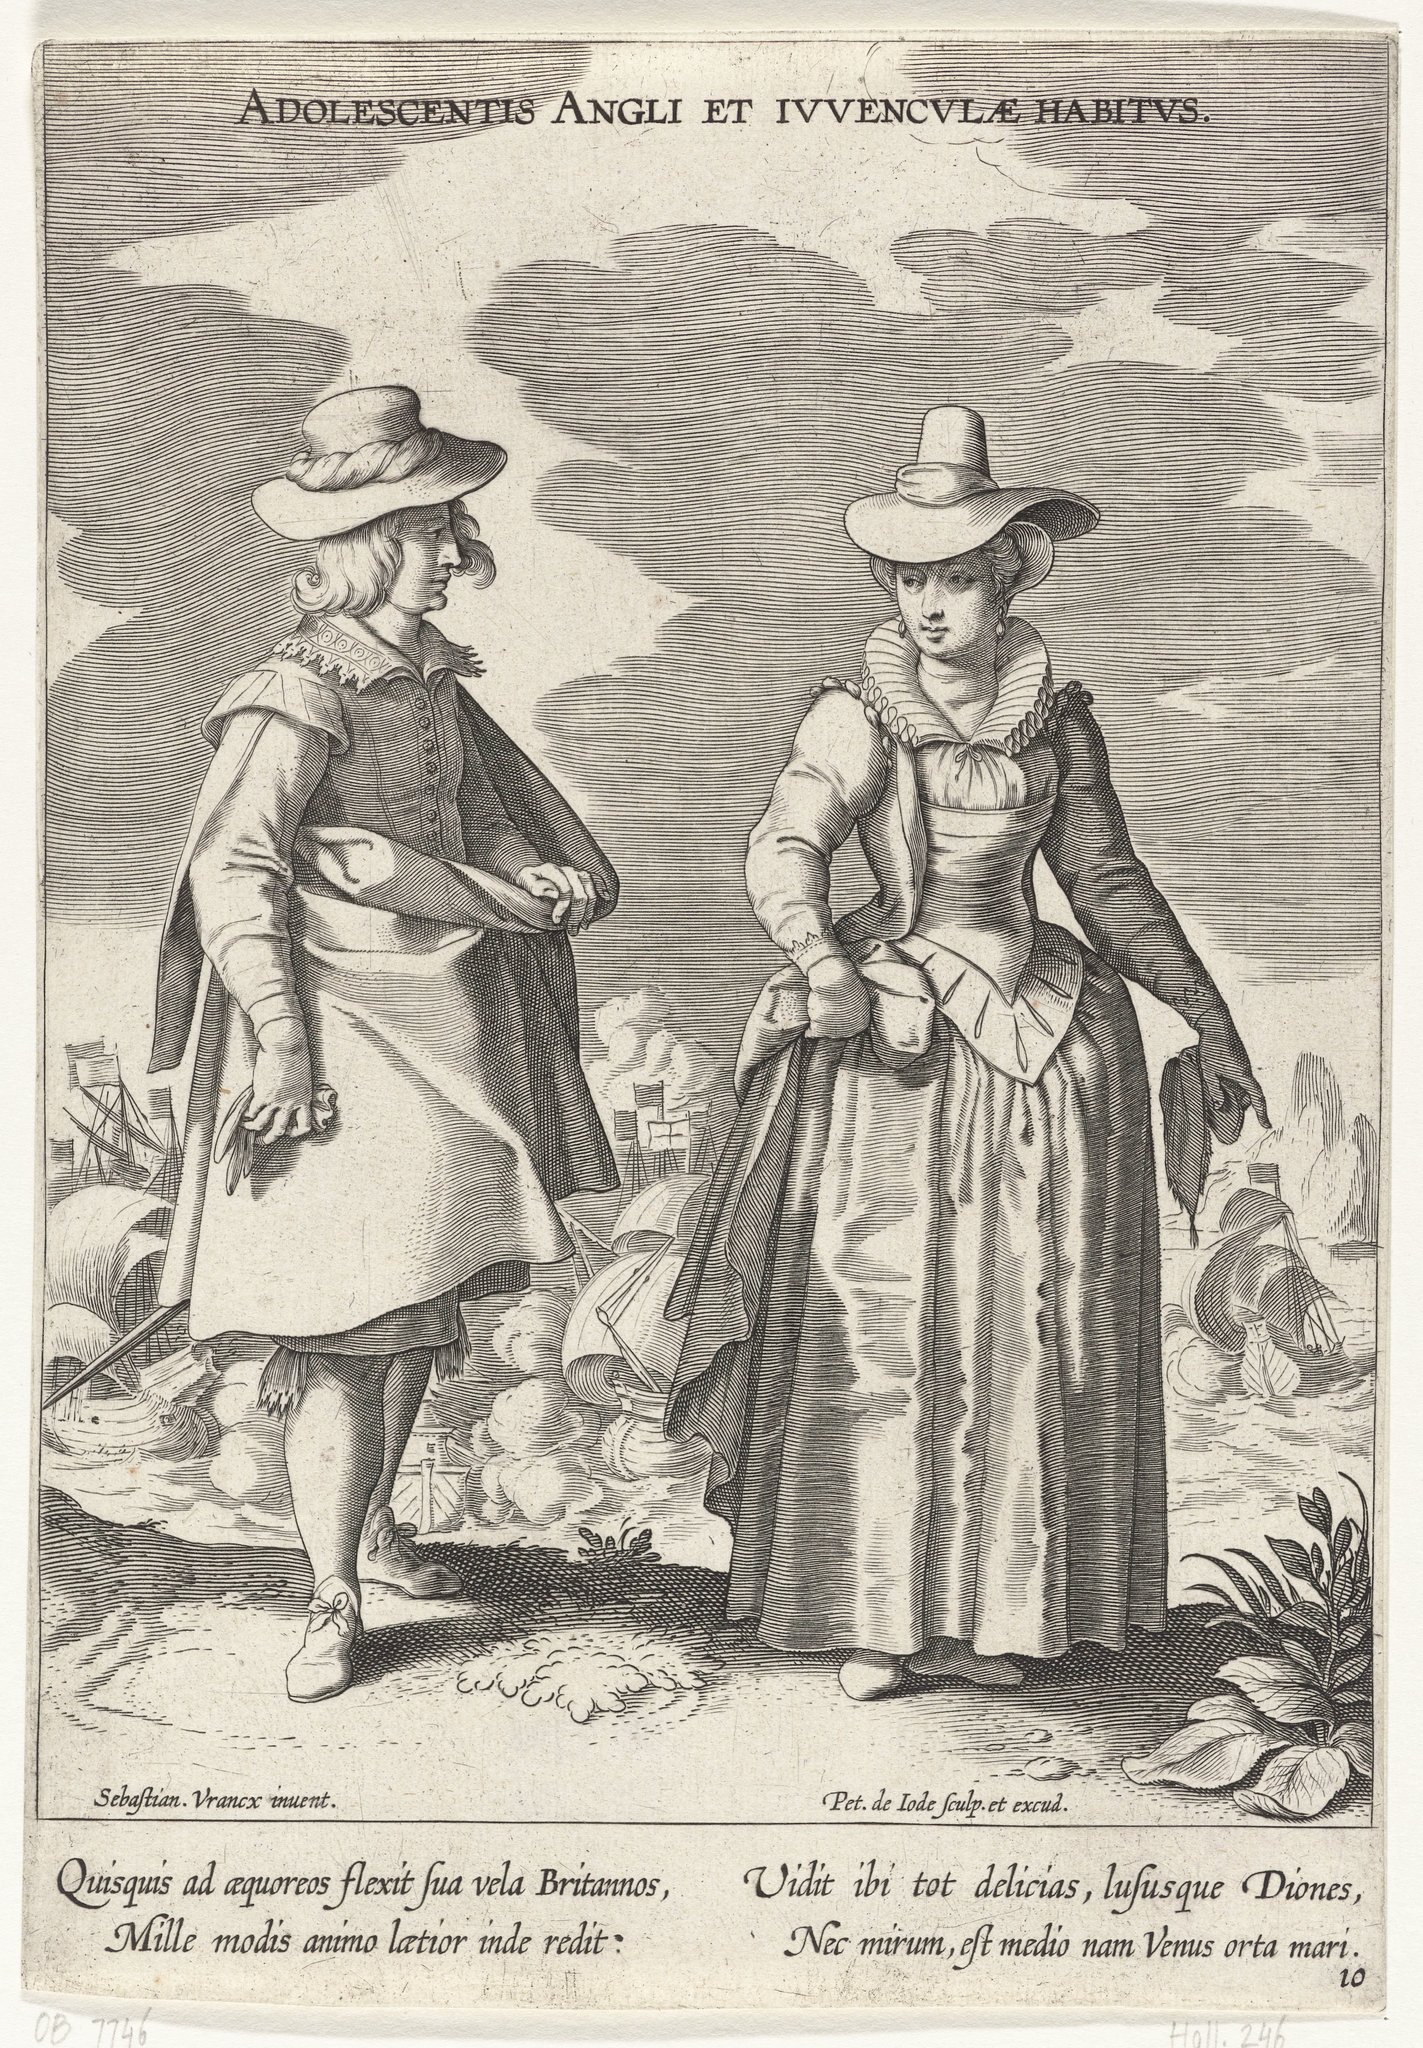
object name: costume print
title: Kostuums uit verschillende landen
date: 1605-1610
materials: paper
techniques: engraving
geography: netherlands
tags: handkerchief (+ women's clothes), coat (+ men's clothes), dress, gown (vlieger) (+ women's clothes), head-gear: hat (+ men's clothes), clothes, costume (+ women's clothes), head-gear: hat (+ women's clothes), neck-gear ~ clothing (with name) (+ women's clothes), skirt (+ women's clothes), sleeves: cuffs (+ women's clothes), shoes, sandals (+ men's clothes), clothes, costume (+ men's clothes), folk costume, regional costume, trousers, breeches, etc. (breeches) (+ men's clothes), clothing for the upper part of the body (doublet) (+ men's clothes), gloves, mittens, etc. (+ men's clothes), sleeves (+ women's clothes), sleeves (+ men's clothes), clothing for the upper part of the body (with name) (+ women's clothes), england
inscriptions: collector's mark: Lugt 240, title: ‘ADOLESCENTIS ANGLI ET IVVENCVLAE HABITVS.’, caption: ‘Quisquis ad aequoreos flexit sua vela Britannos,/ Mille modis animo laetior inde redit: / Vidit ibi tot delicias, lususque Diones, Nec mirum, est medio nam Venus orta mari.’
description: Landschap met een paar, gekleed volgens de Engelse mode. De vrouw heeft een zakdoek in haar linkerhand en de man heeft een paar handschoenen in zijn rechterhand. Op de achtergrond diverse zeilschepen op water. In de marge, in twee kolommen, een onderschrift in het Latijn over de Britse zeevaart en de liefdesspelletjes van de Britten. Tiende prent uit een serie van tien met kostuums uit verschillende landen.